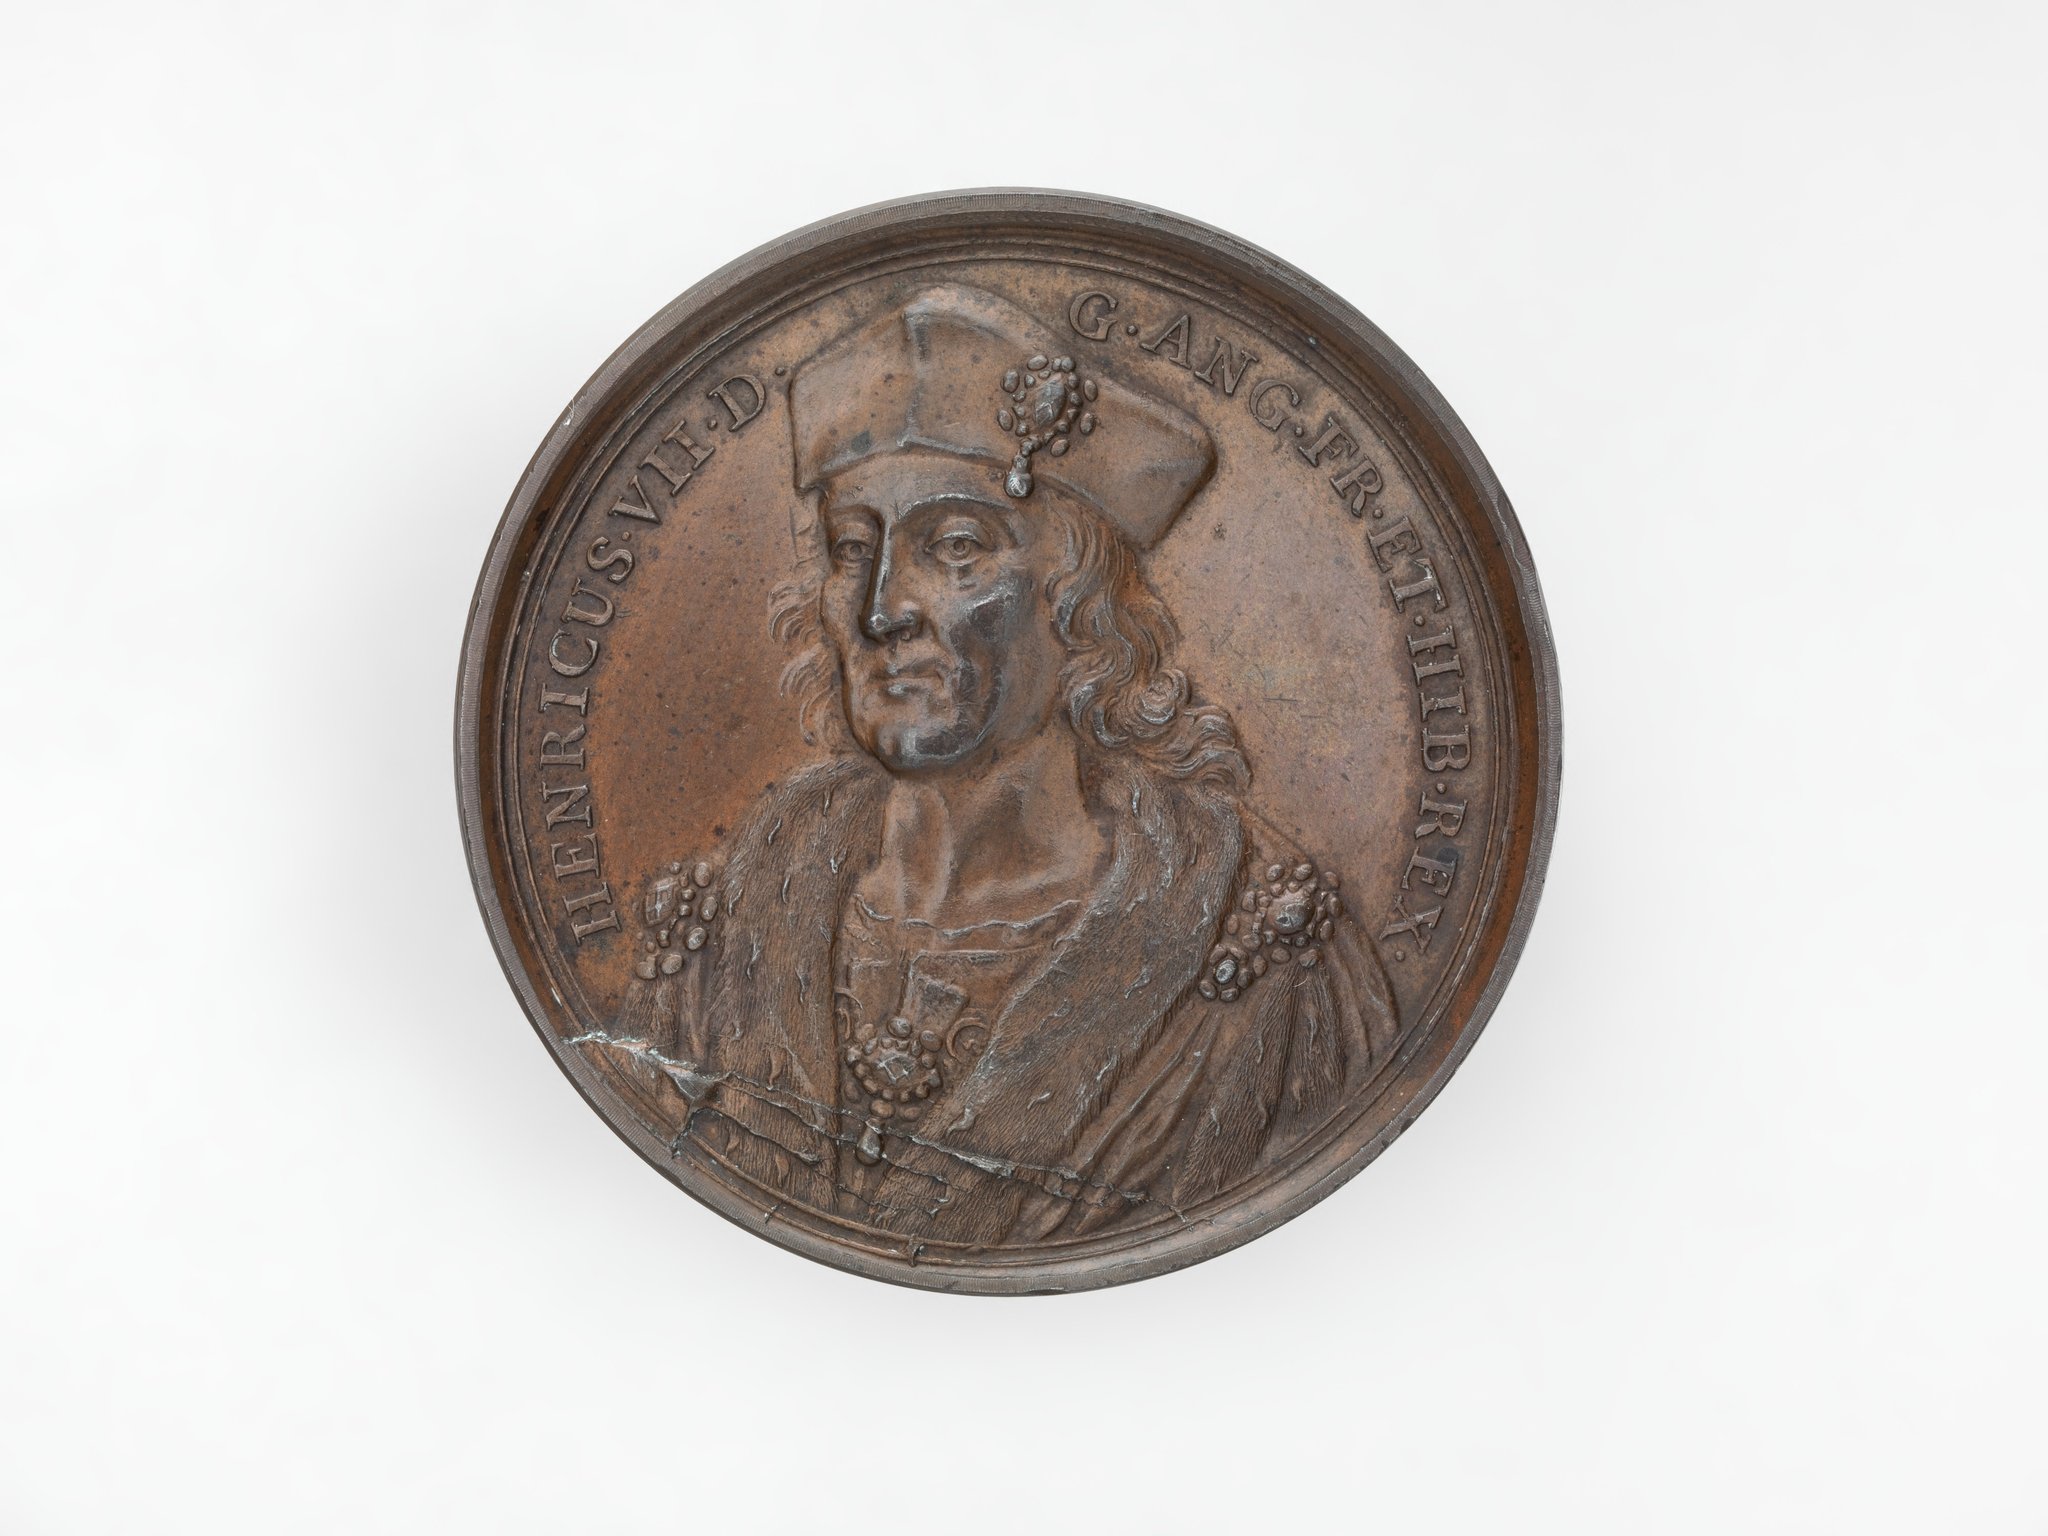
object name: medal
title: Henry VII, from the English Monarchs series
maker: jean dassier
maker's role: artist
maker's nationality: swiss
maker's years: 1676-1763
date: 1731-1732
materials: bronze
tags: kings,portraits